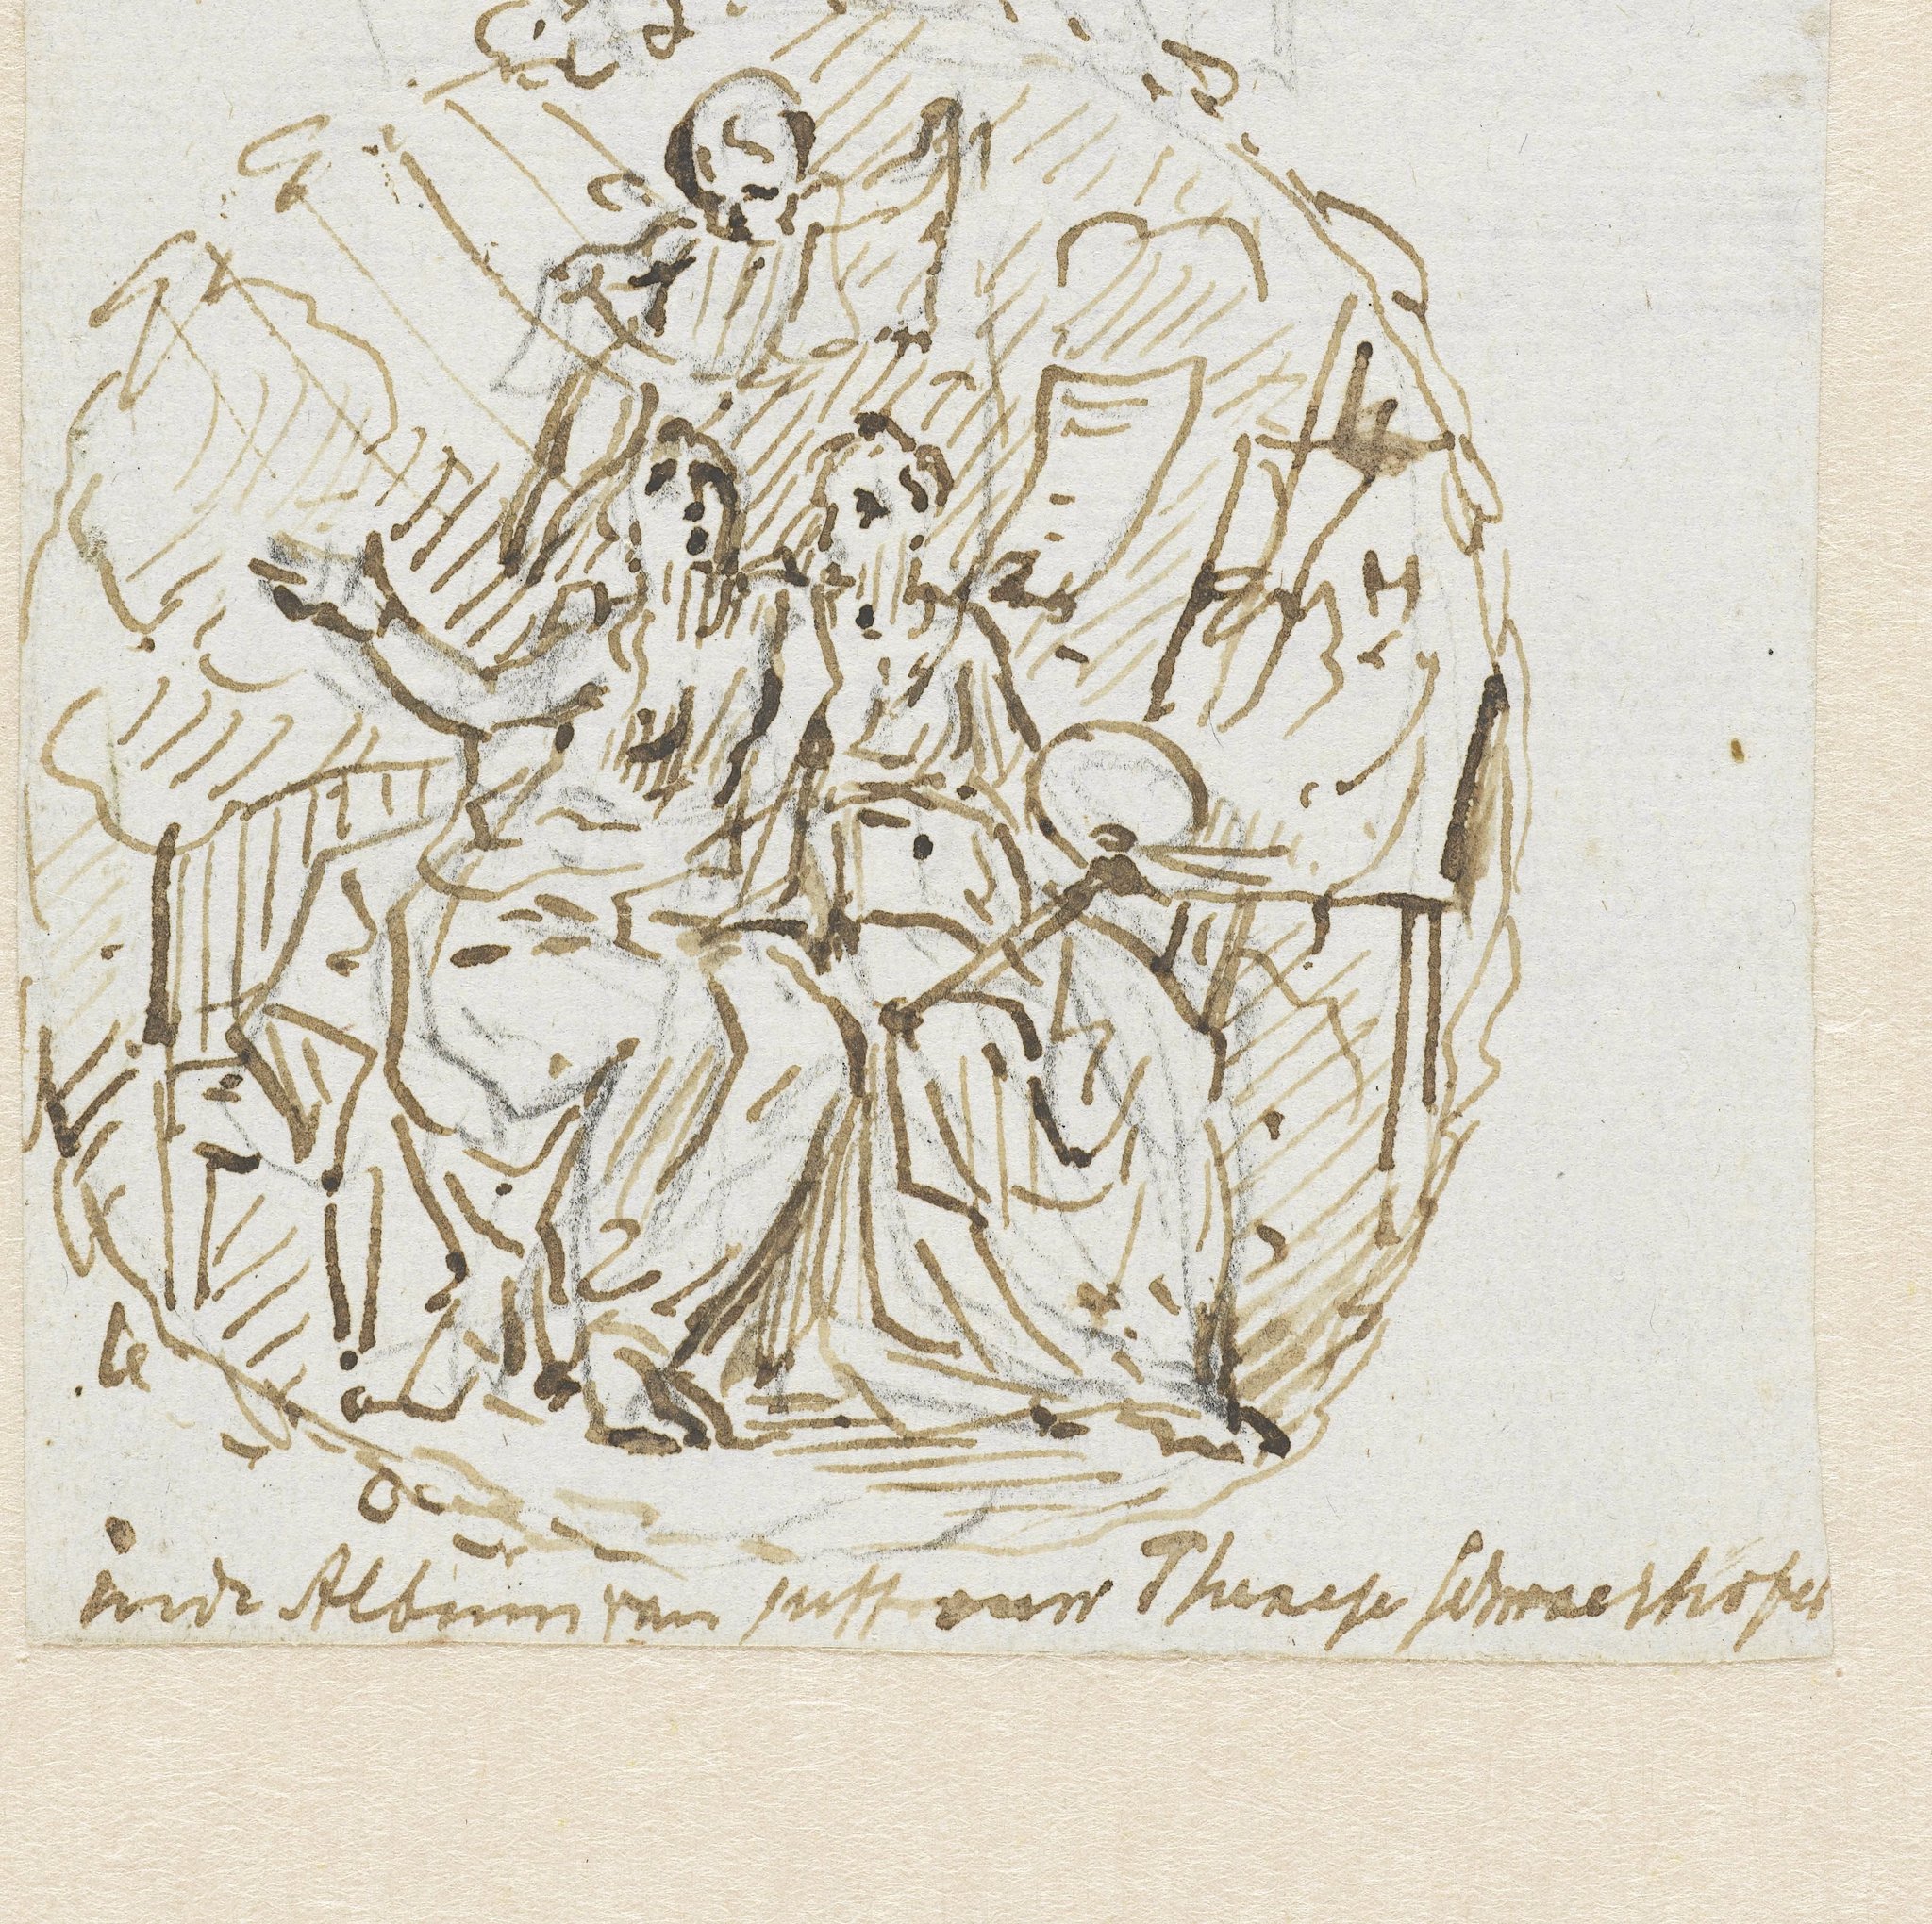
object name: drawing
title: Zangkunst en Schilderkunst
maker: jurriaan andriessen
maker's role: draughtsman, painter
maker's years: 1742-1819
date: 1794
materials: graphite, ink, paper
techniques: pen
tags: 'pictura', symbolic representations, allegories and emblems ~ painting; 'pittura' (ripa), vocal music, singing